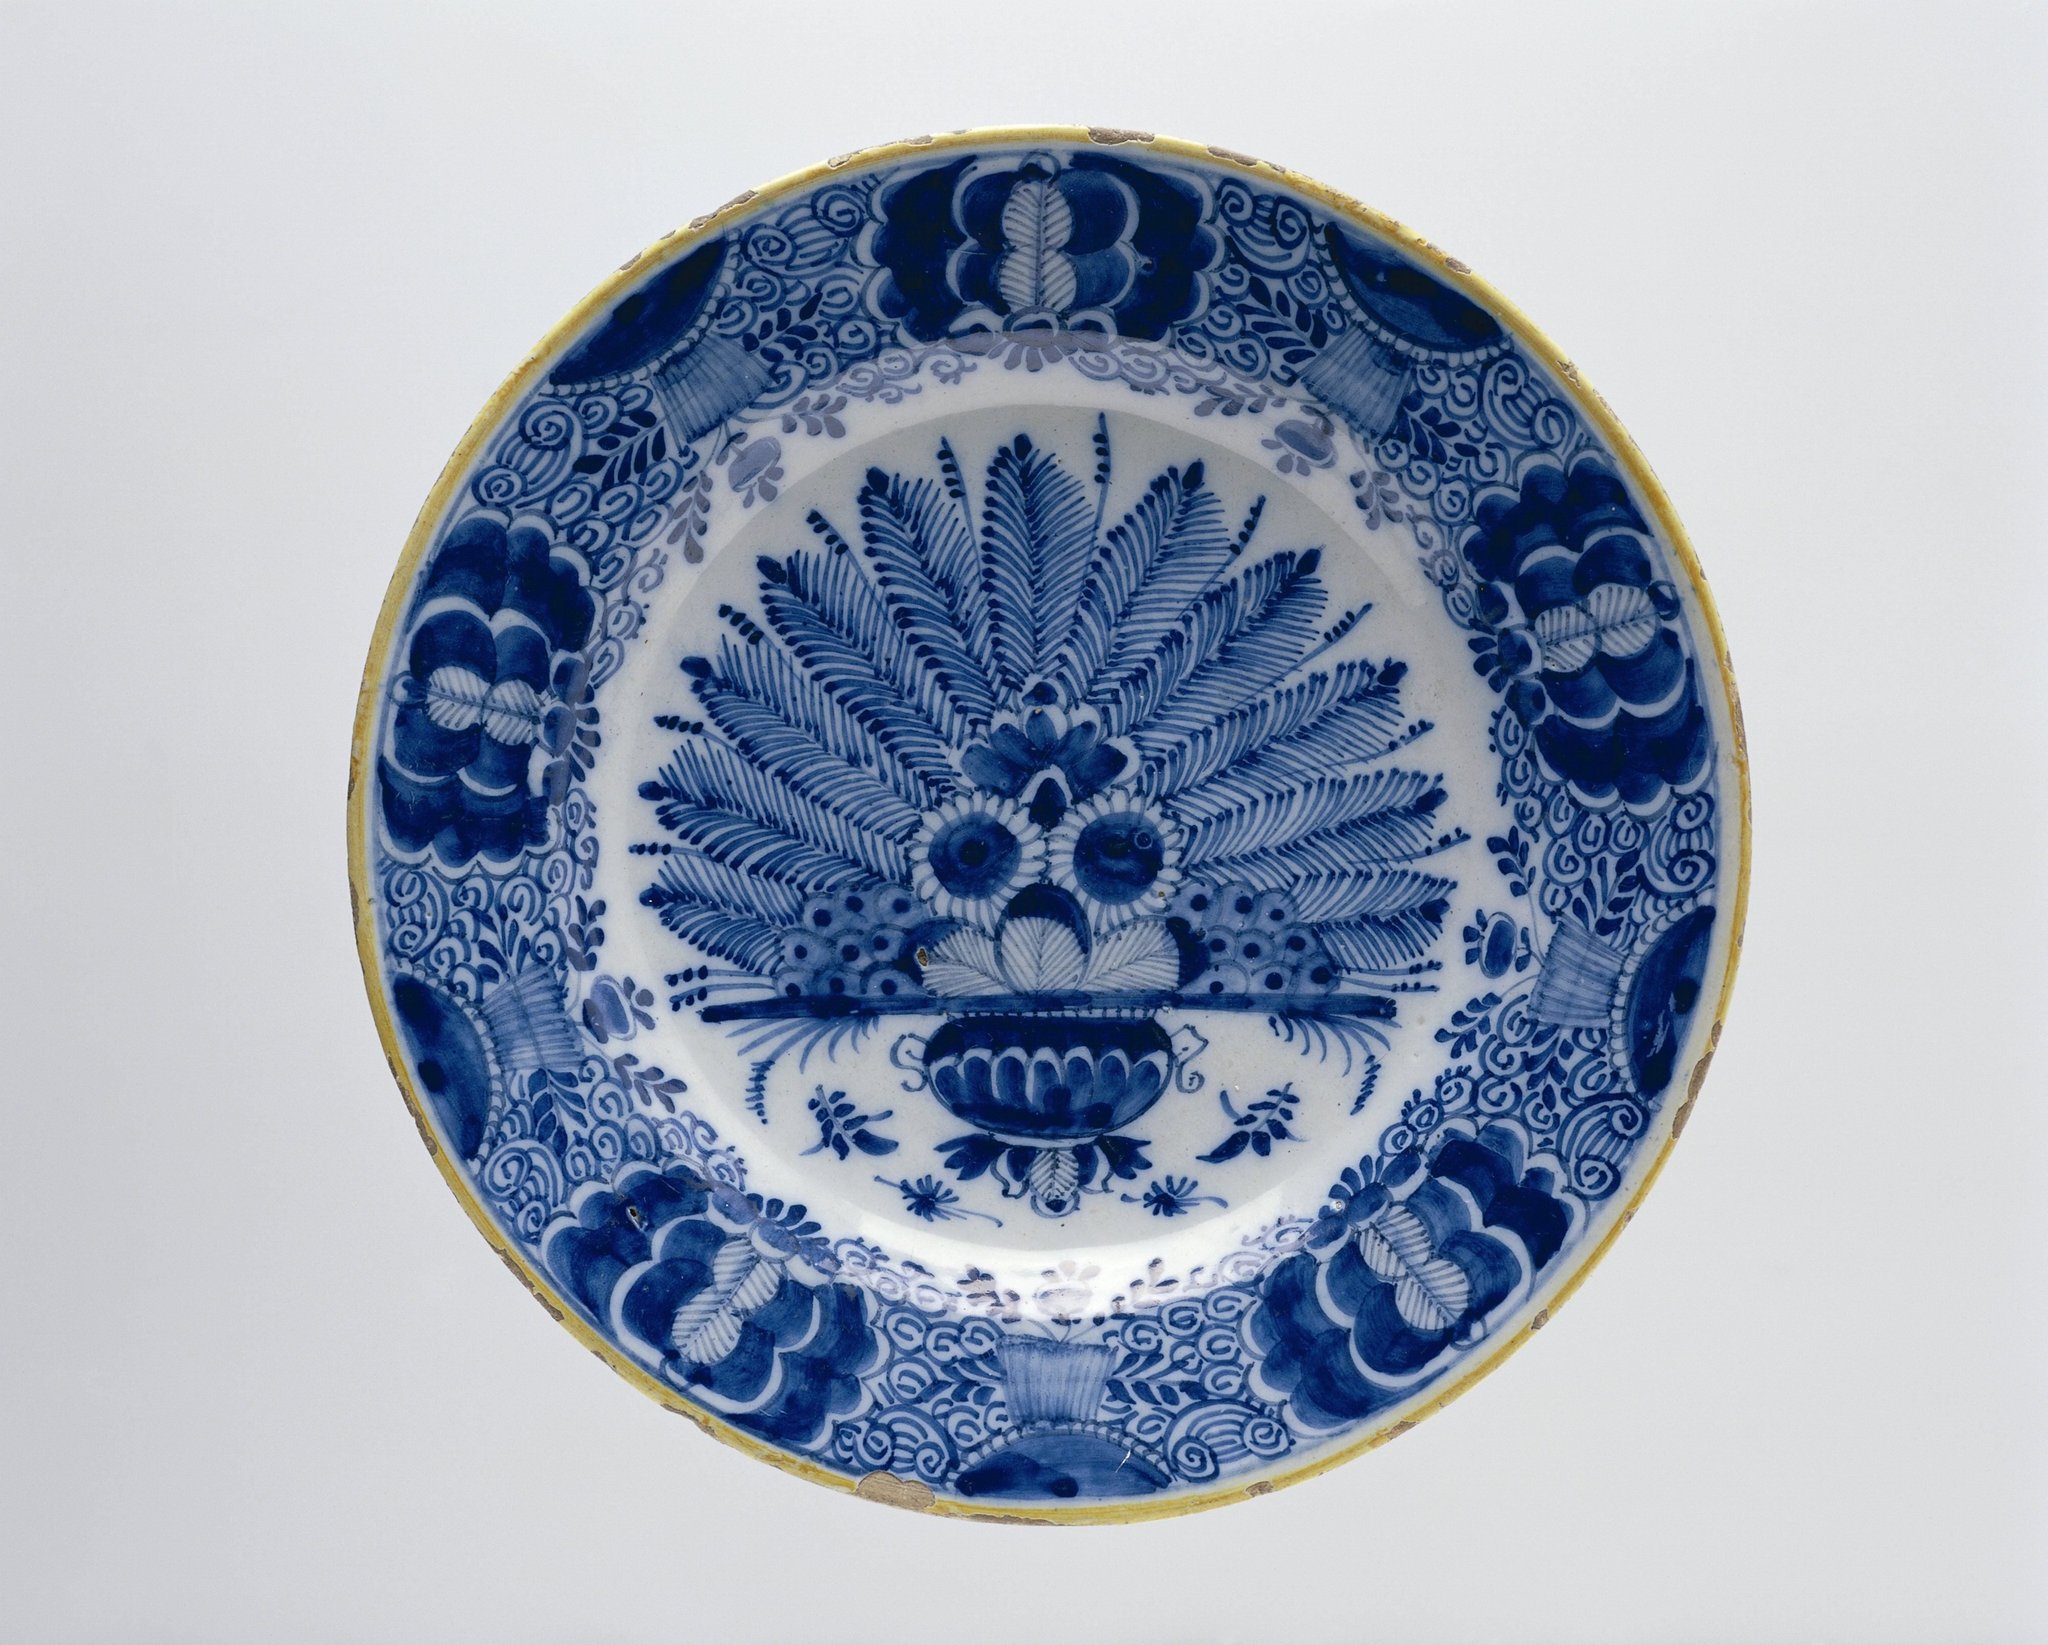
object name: plate dish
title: Bord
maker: Anonymous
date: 1760-1800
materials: faience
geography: delft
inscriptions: mark: ‘A/ DW5 of S’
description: Bord van faience, met gele bies. Blauw beschilderd met een pauwenveerdecoratie. Gemerkt.